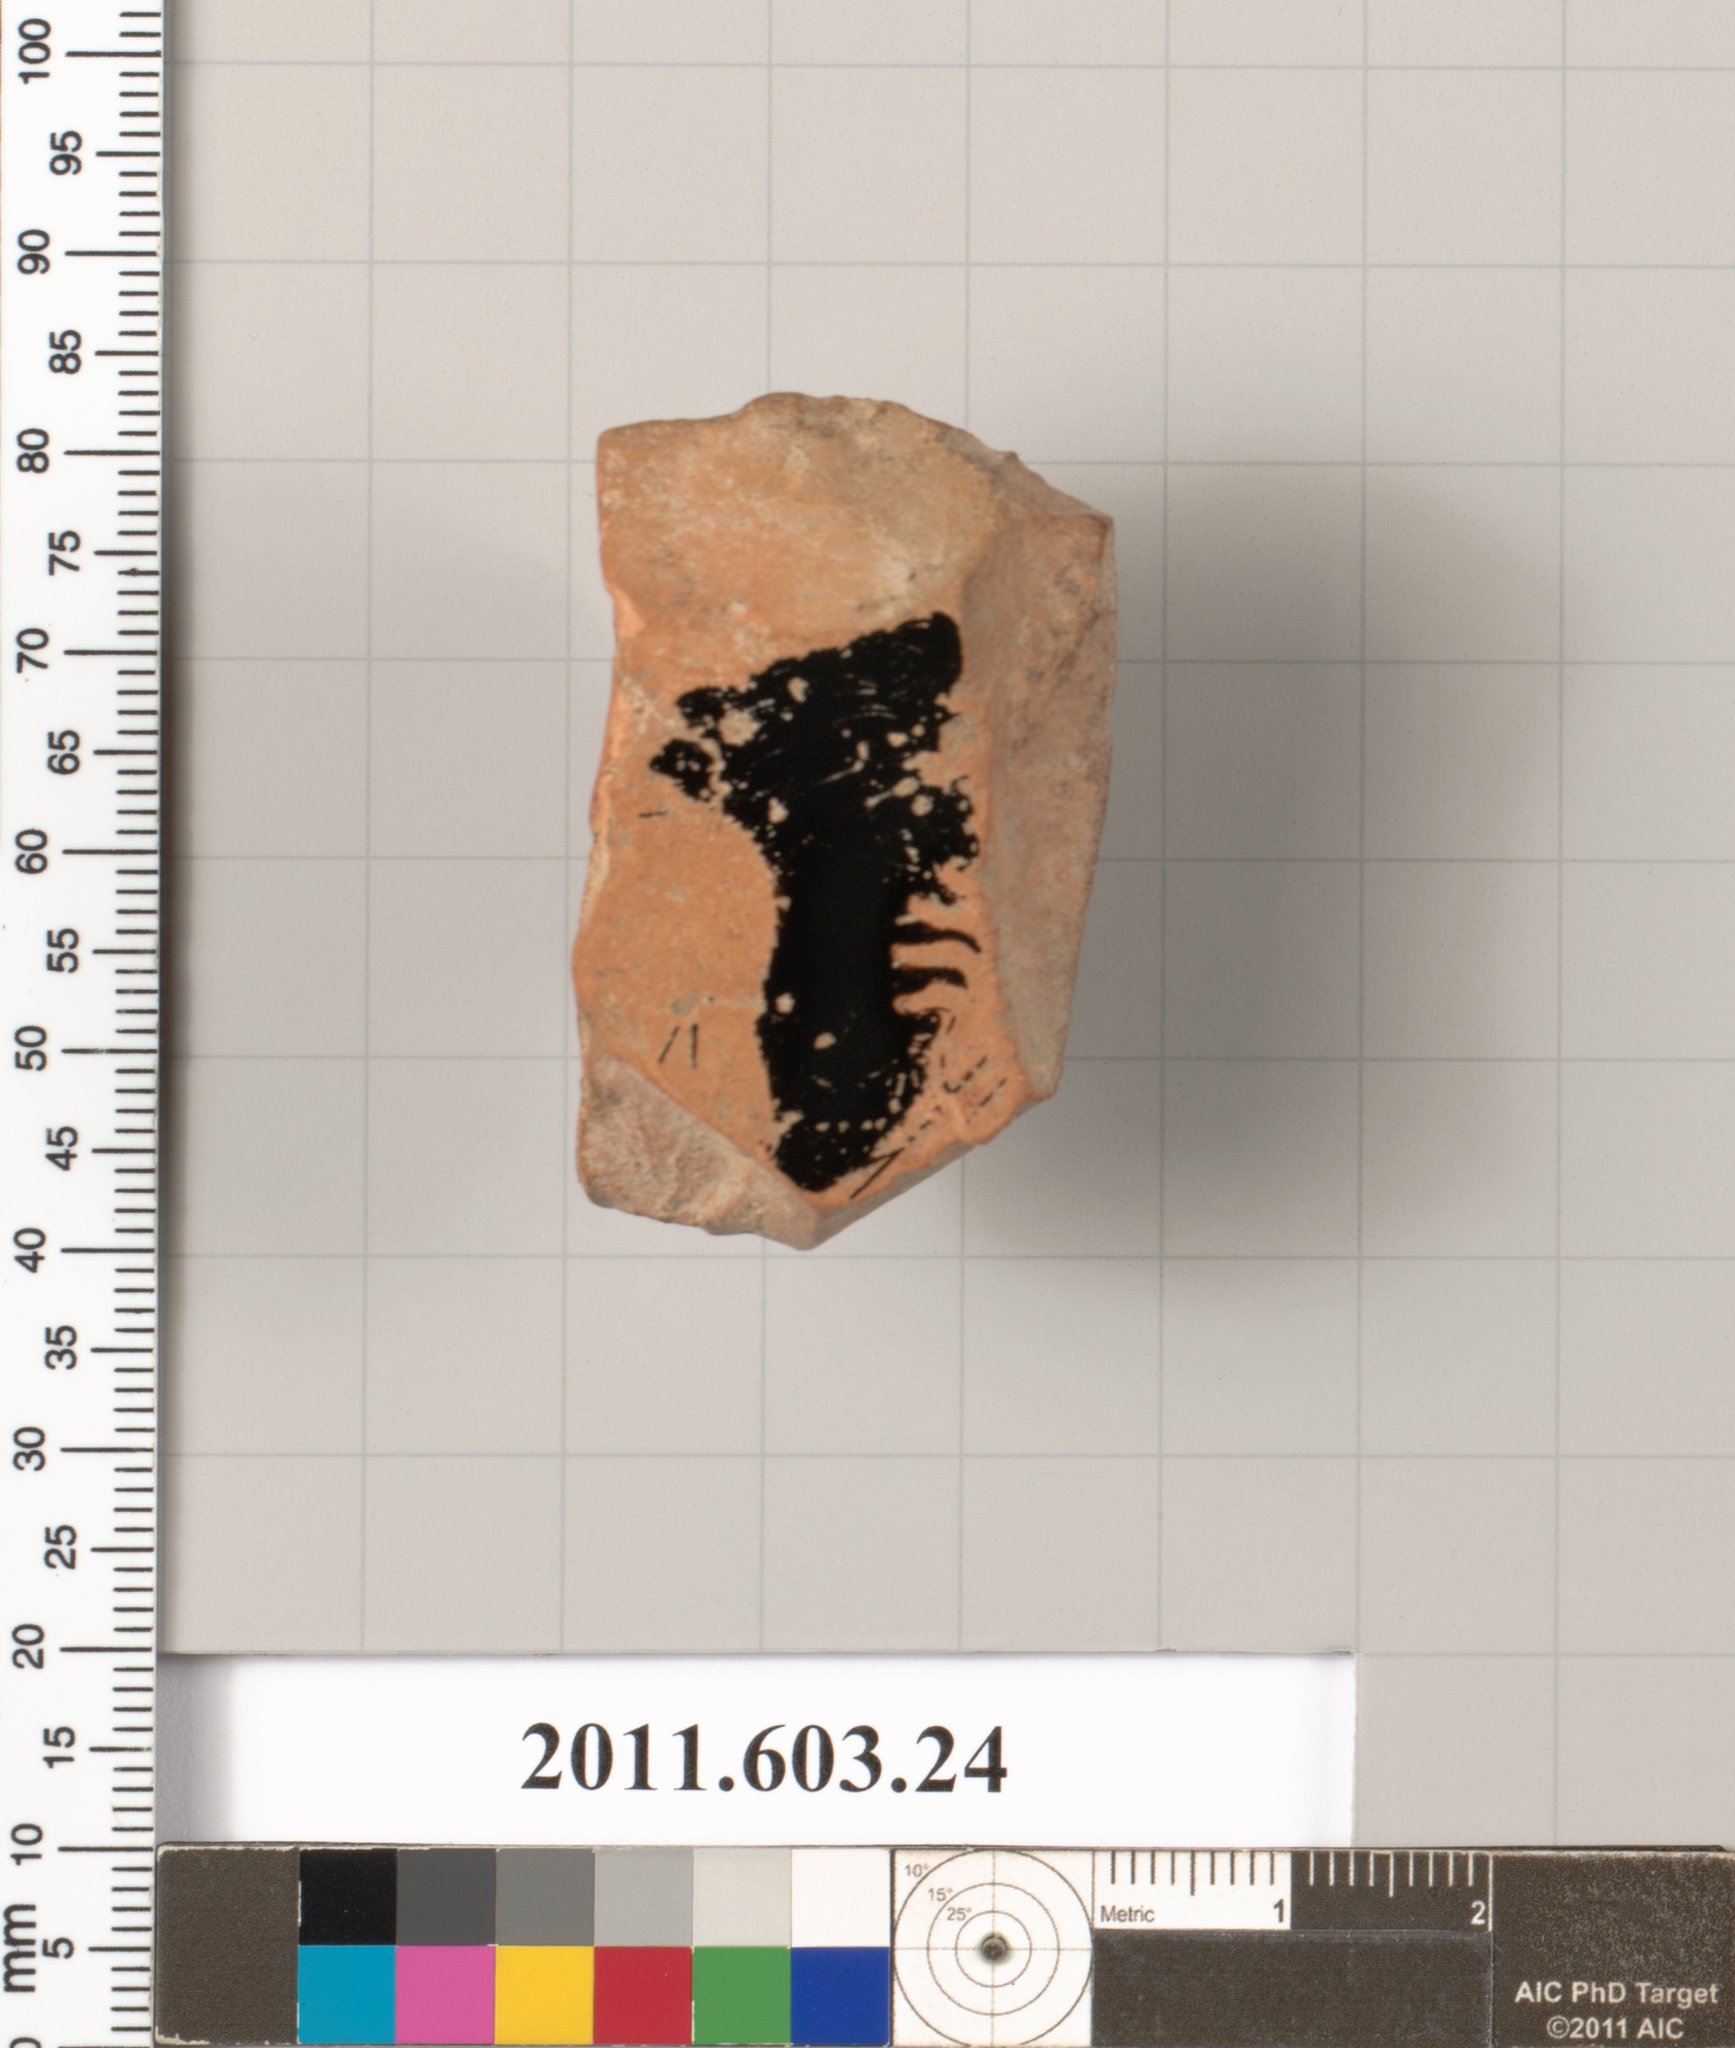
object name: kylix fragment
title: Fragment of a terracotta kylix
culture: greek, attic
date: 534-468 BCE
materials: terracotta